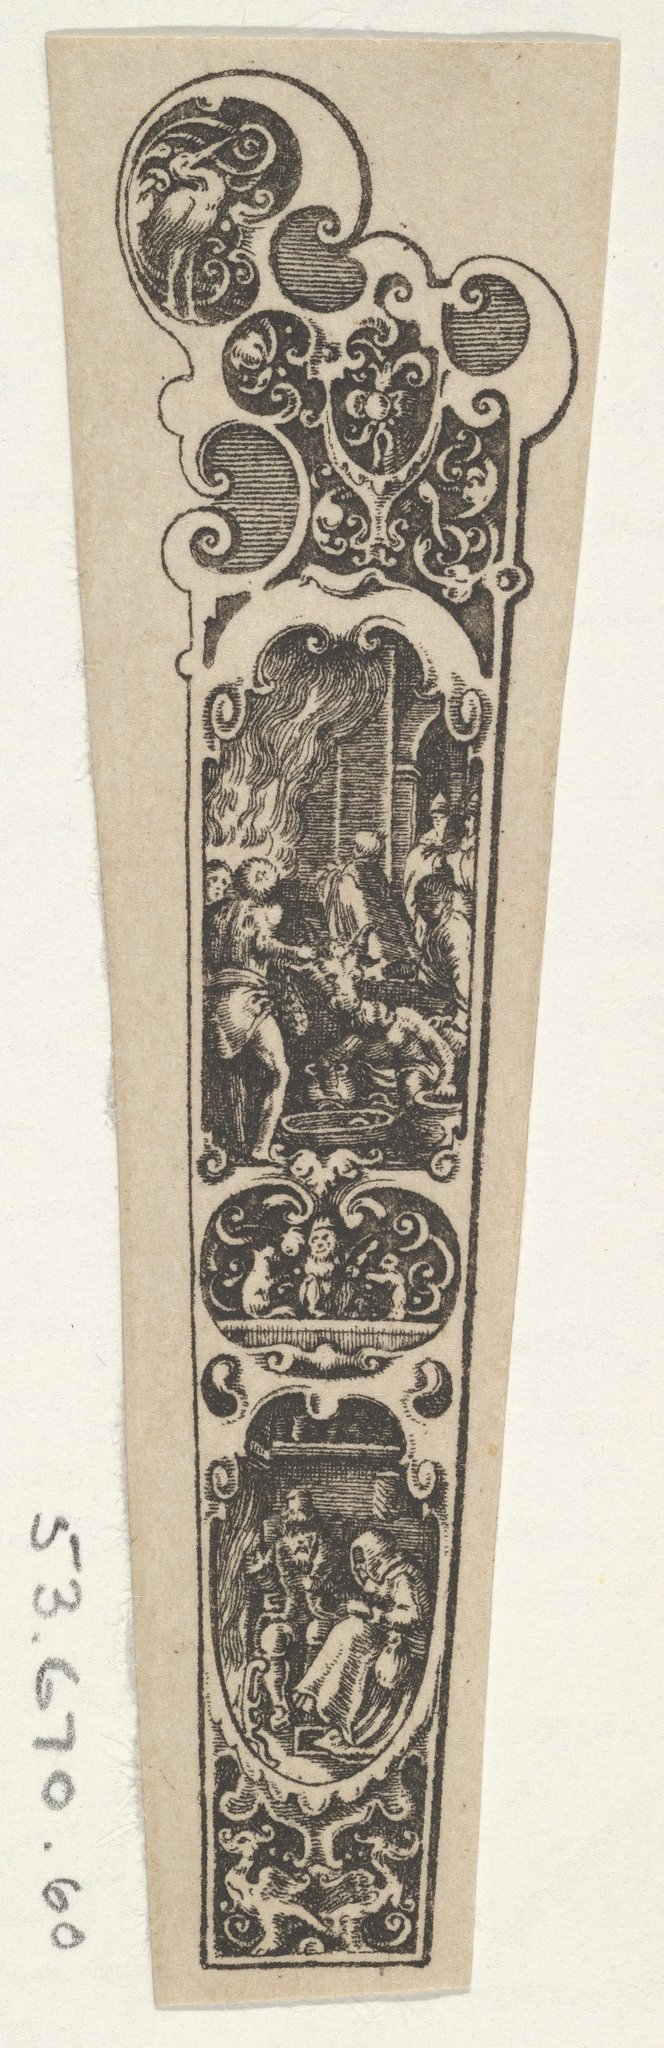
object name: print ornament architecture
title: Design for a Knife Handle with a Couple Gathered Around a Fire at Bottom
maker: johann theodor de bry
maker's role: artist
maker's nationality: netherlandish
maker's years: 1561-1623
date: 1580-1600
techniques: embroidery, engraving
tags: cranes,hilts,men,women,fire